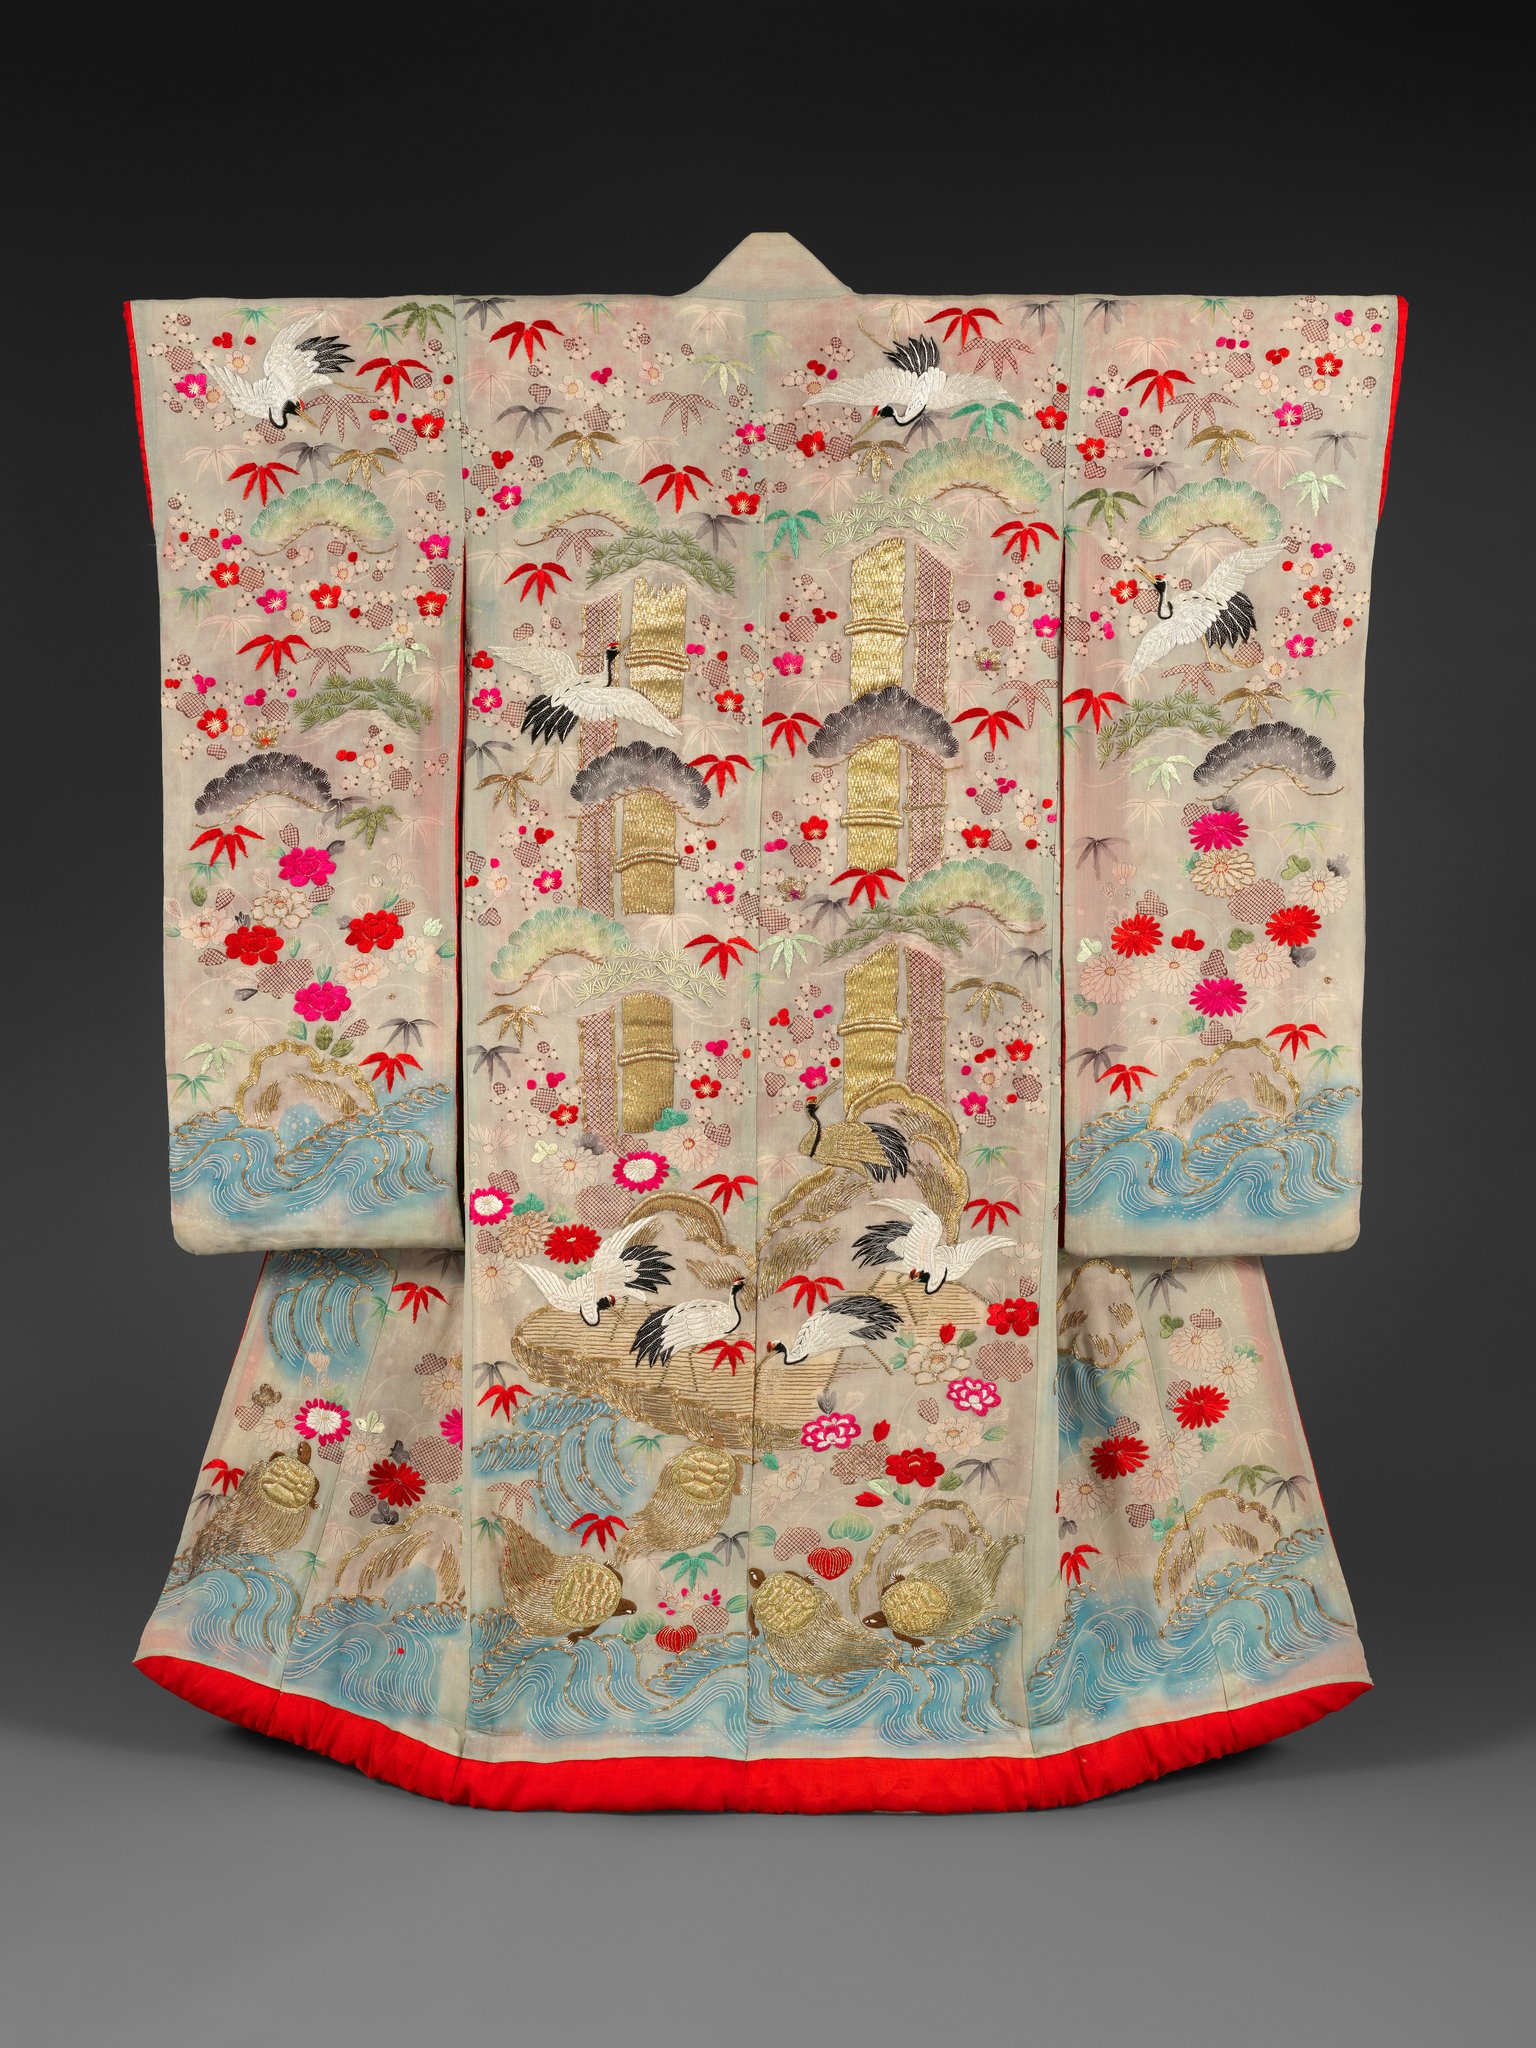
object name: outer robe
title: Outer Robe (Uchikake) with Mount Penglai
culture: japanese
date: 1834-1866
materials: gold thread, paste, silk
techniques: dyeing, embroidery, resist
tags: cranes,turtles,bamboo